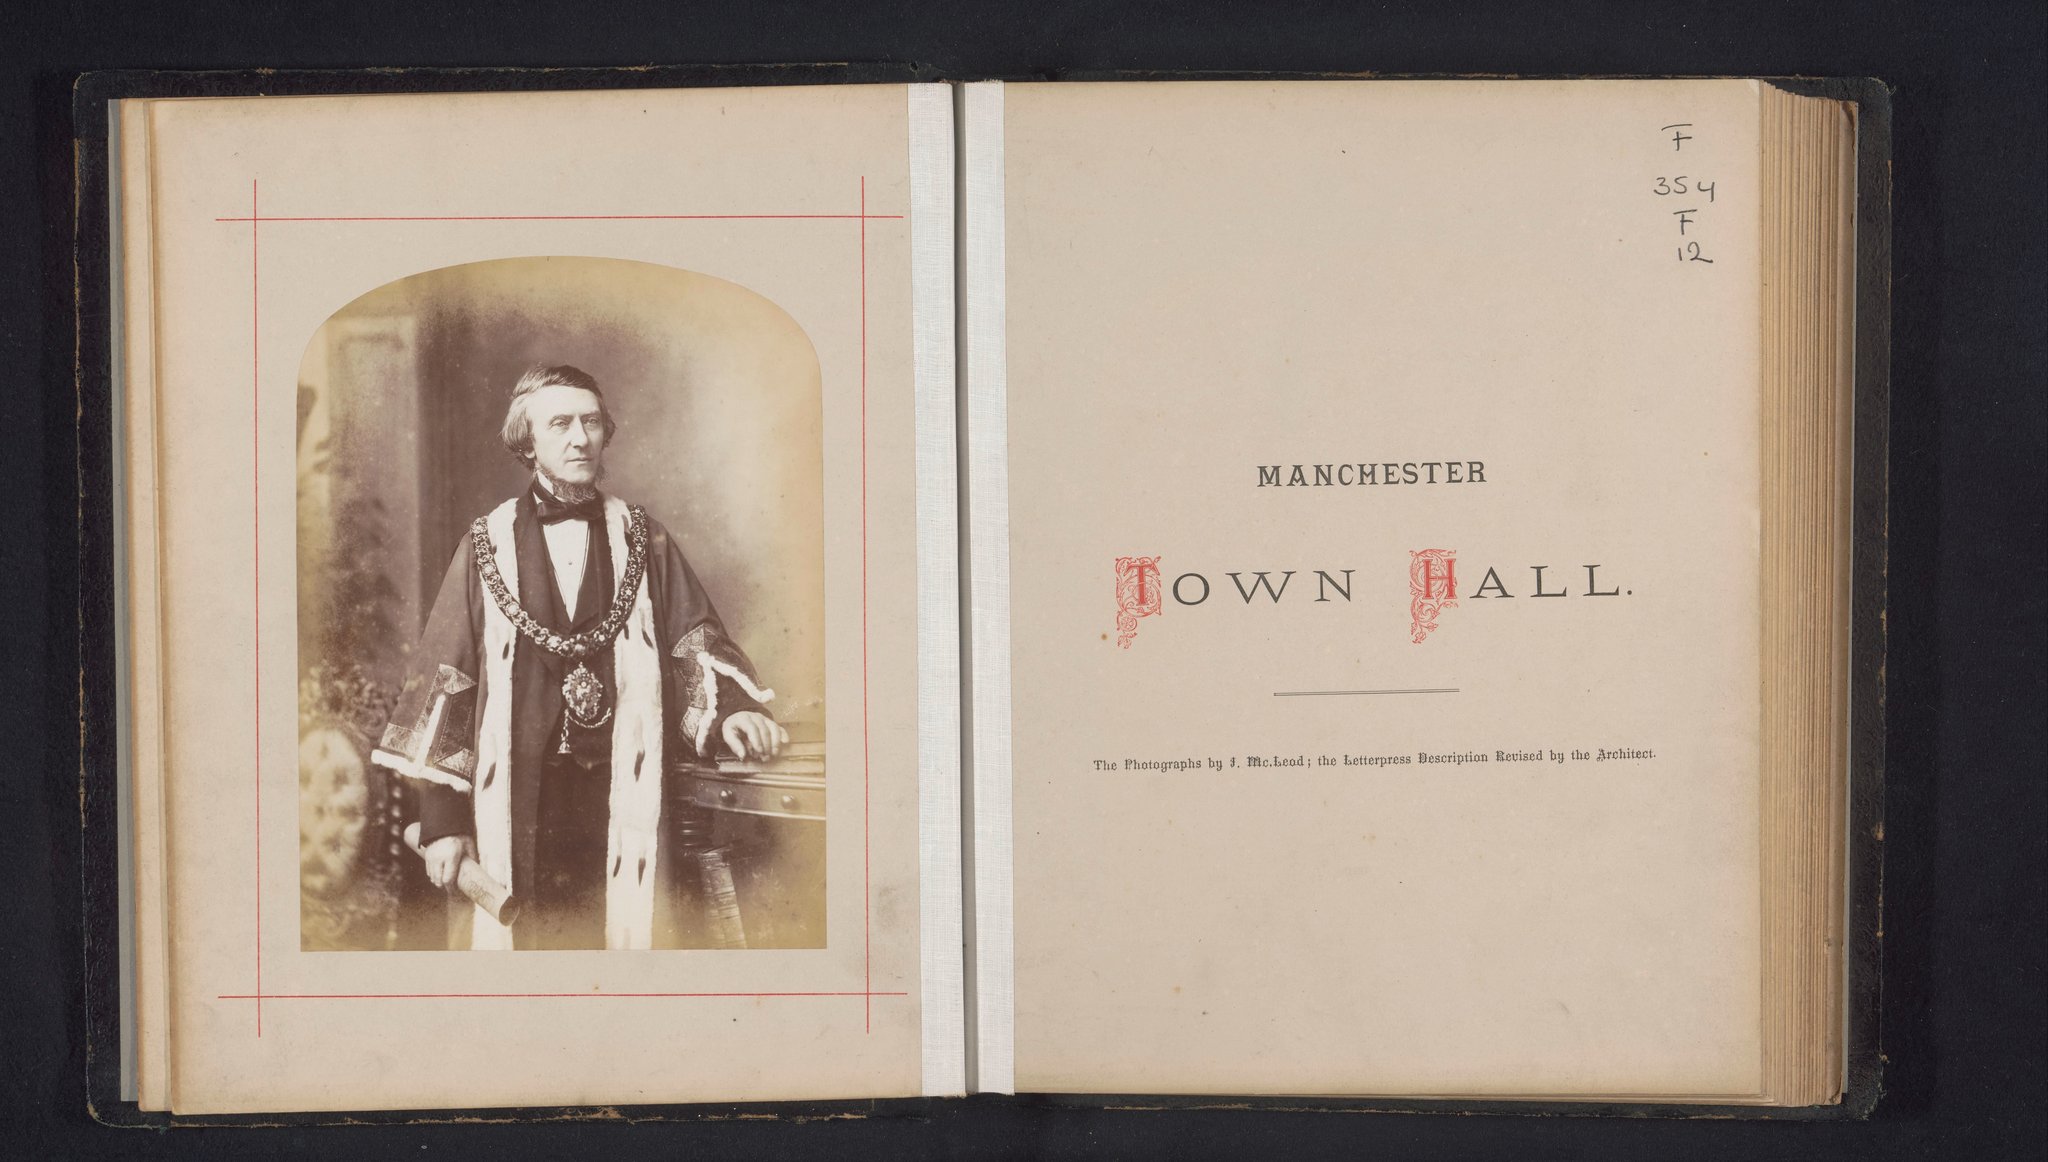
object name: photograph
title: Portret van burgemeester Abel Heywood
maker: j. mcleod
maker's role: fotograaf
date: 1876-1877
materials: photographic support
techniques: albumen print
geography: manchester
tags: mayor, mayor, burgomaster